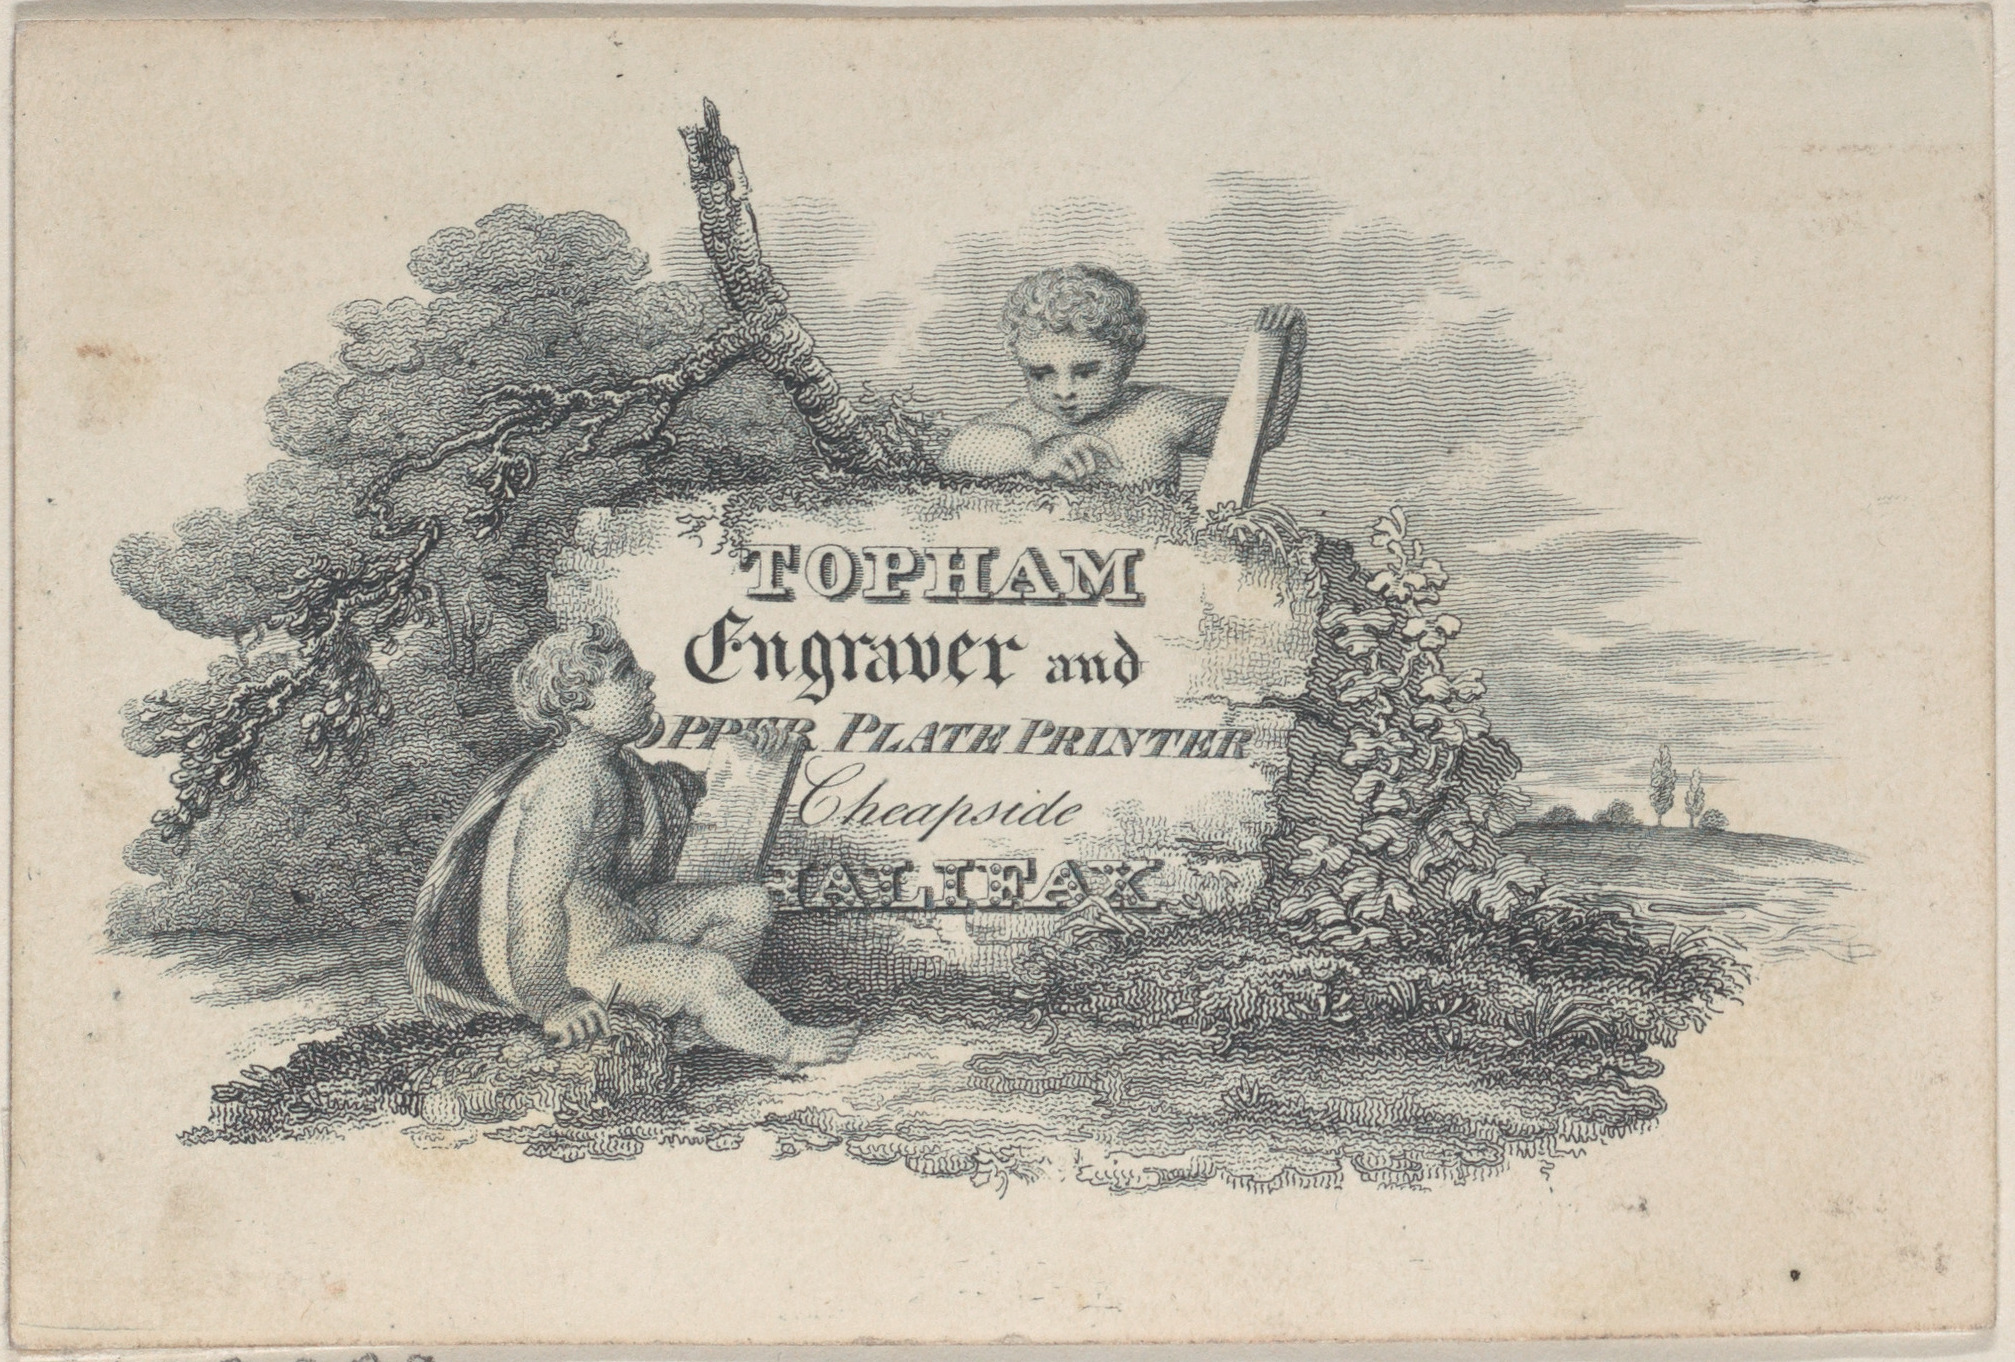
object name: print, trade card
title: Trade Card for Topham, Engraver and Copper Plate Printer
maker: anonymous, british, 19th century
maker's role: artist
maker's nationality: british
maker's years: 1800-1900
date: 1801-1900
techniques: engraving